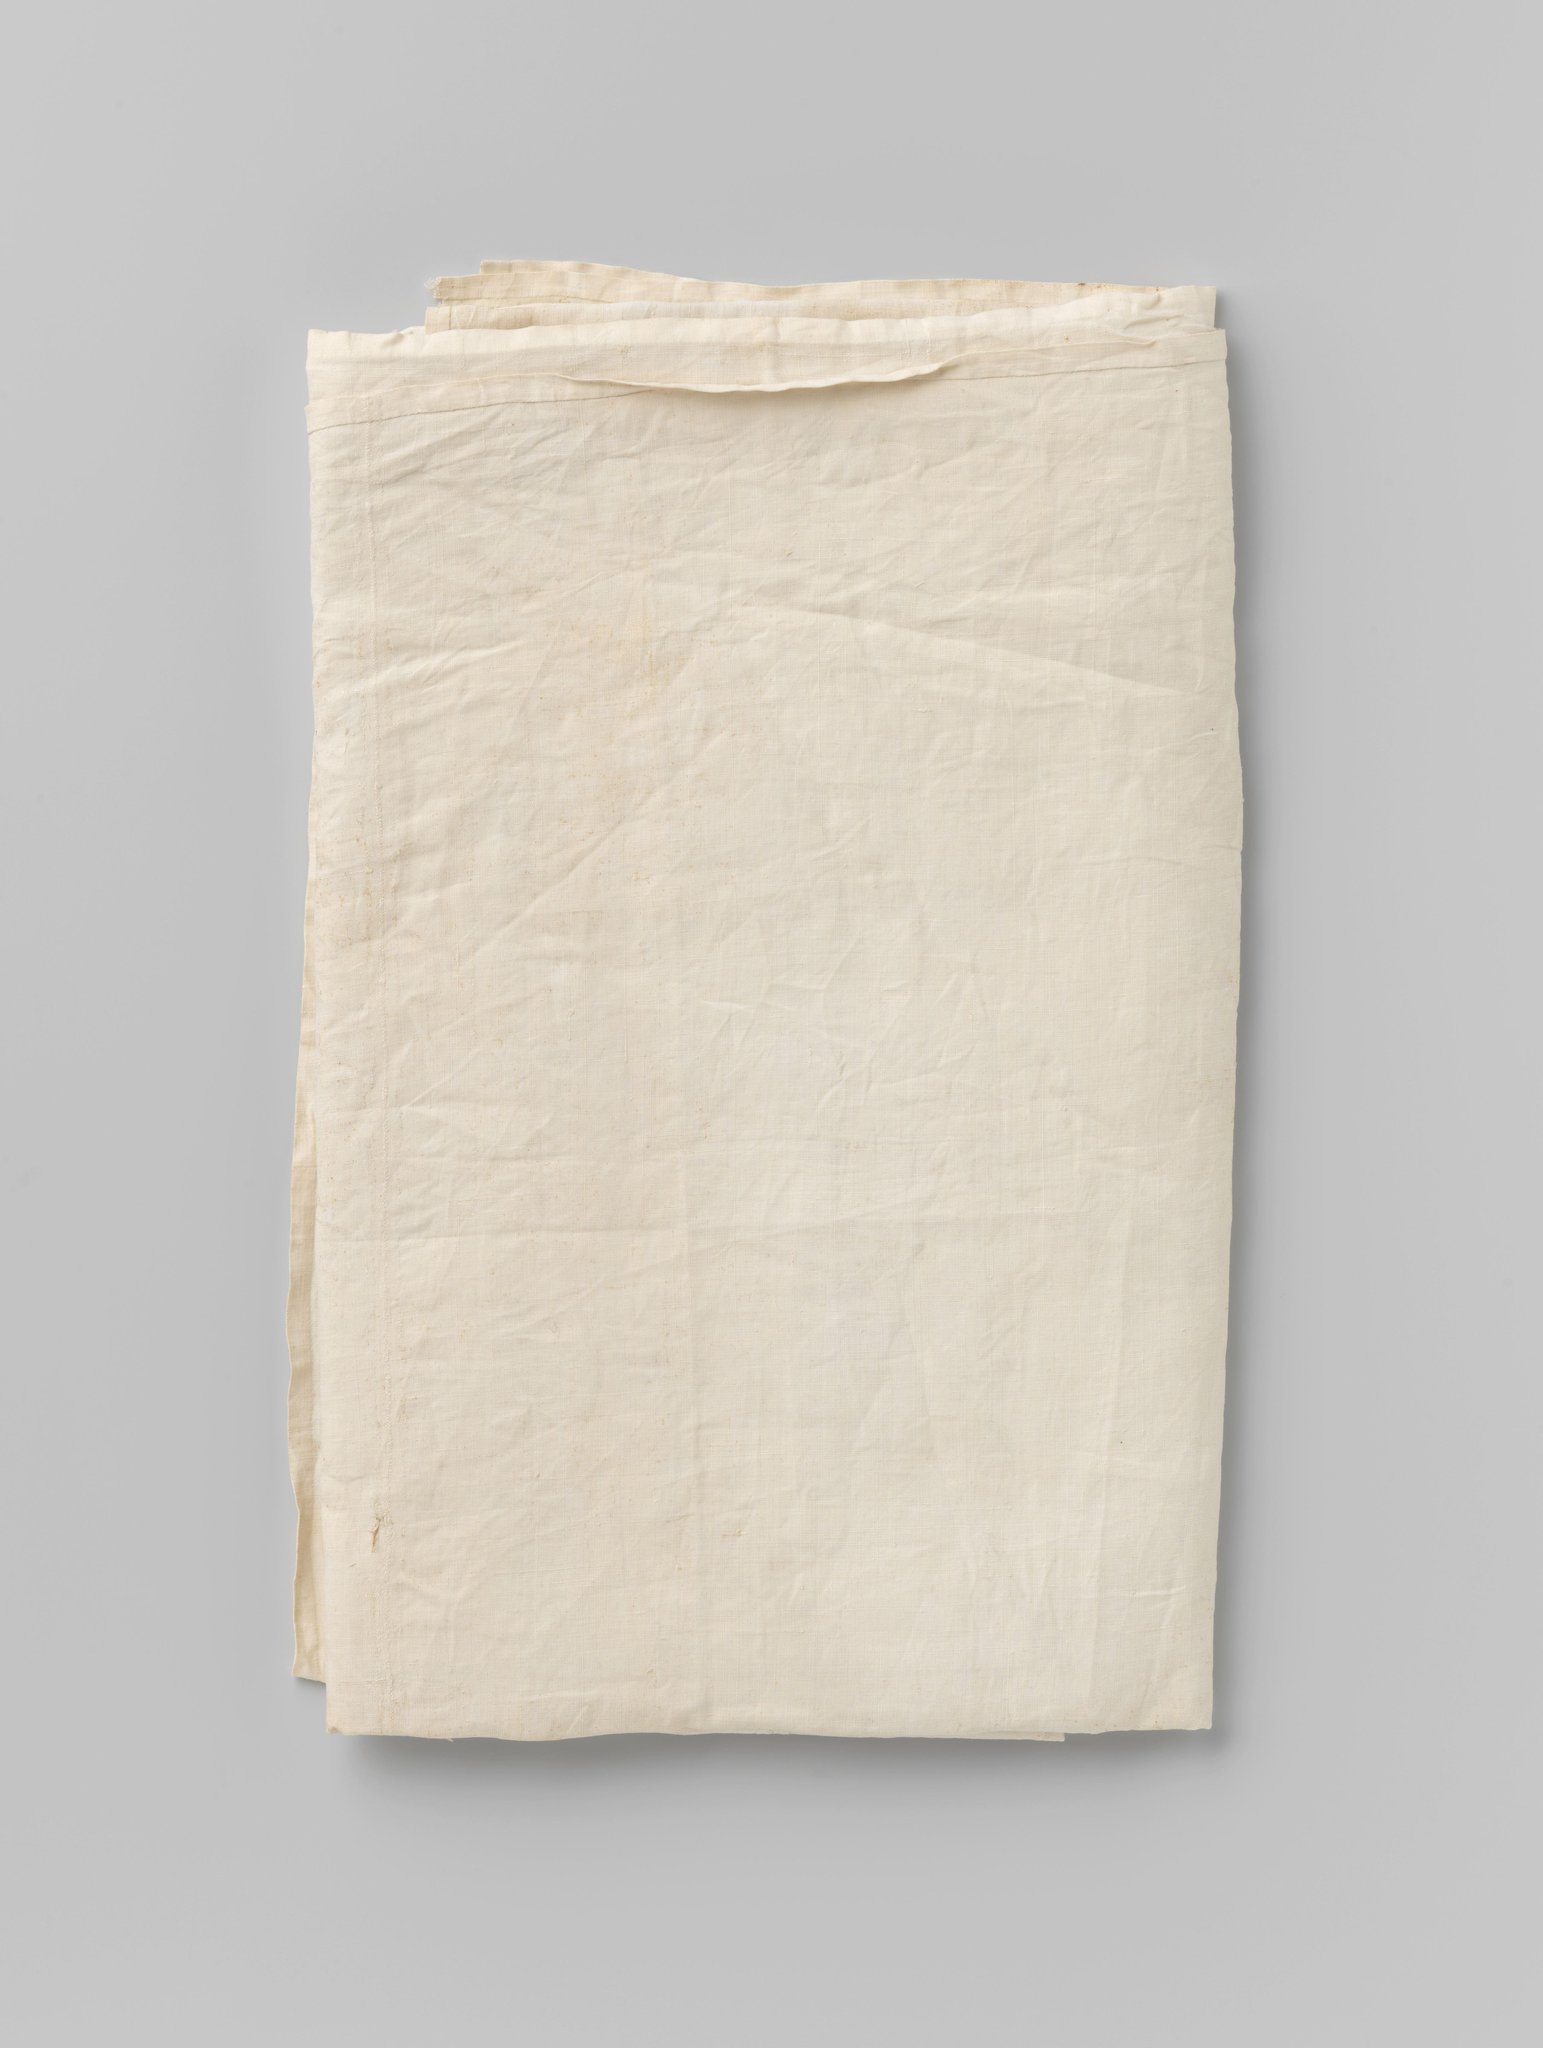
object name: beddenlaken, laken object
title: Laken, fragment. Merk: 1716 2.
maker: Anonymous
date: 1716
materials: linen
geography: northern netherlands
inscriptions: date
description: Laken, fragment van wit linnen gemerkt 1716 2.